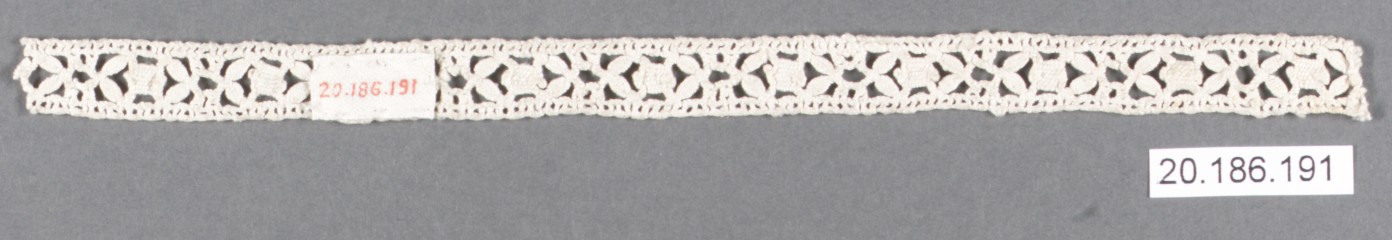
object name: insertion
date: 1601-1700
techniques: lace